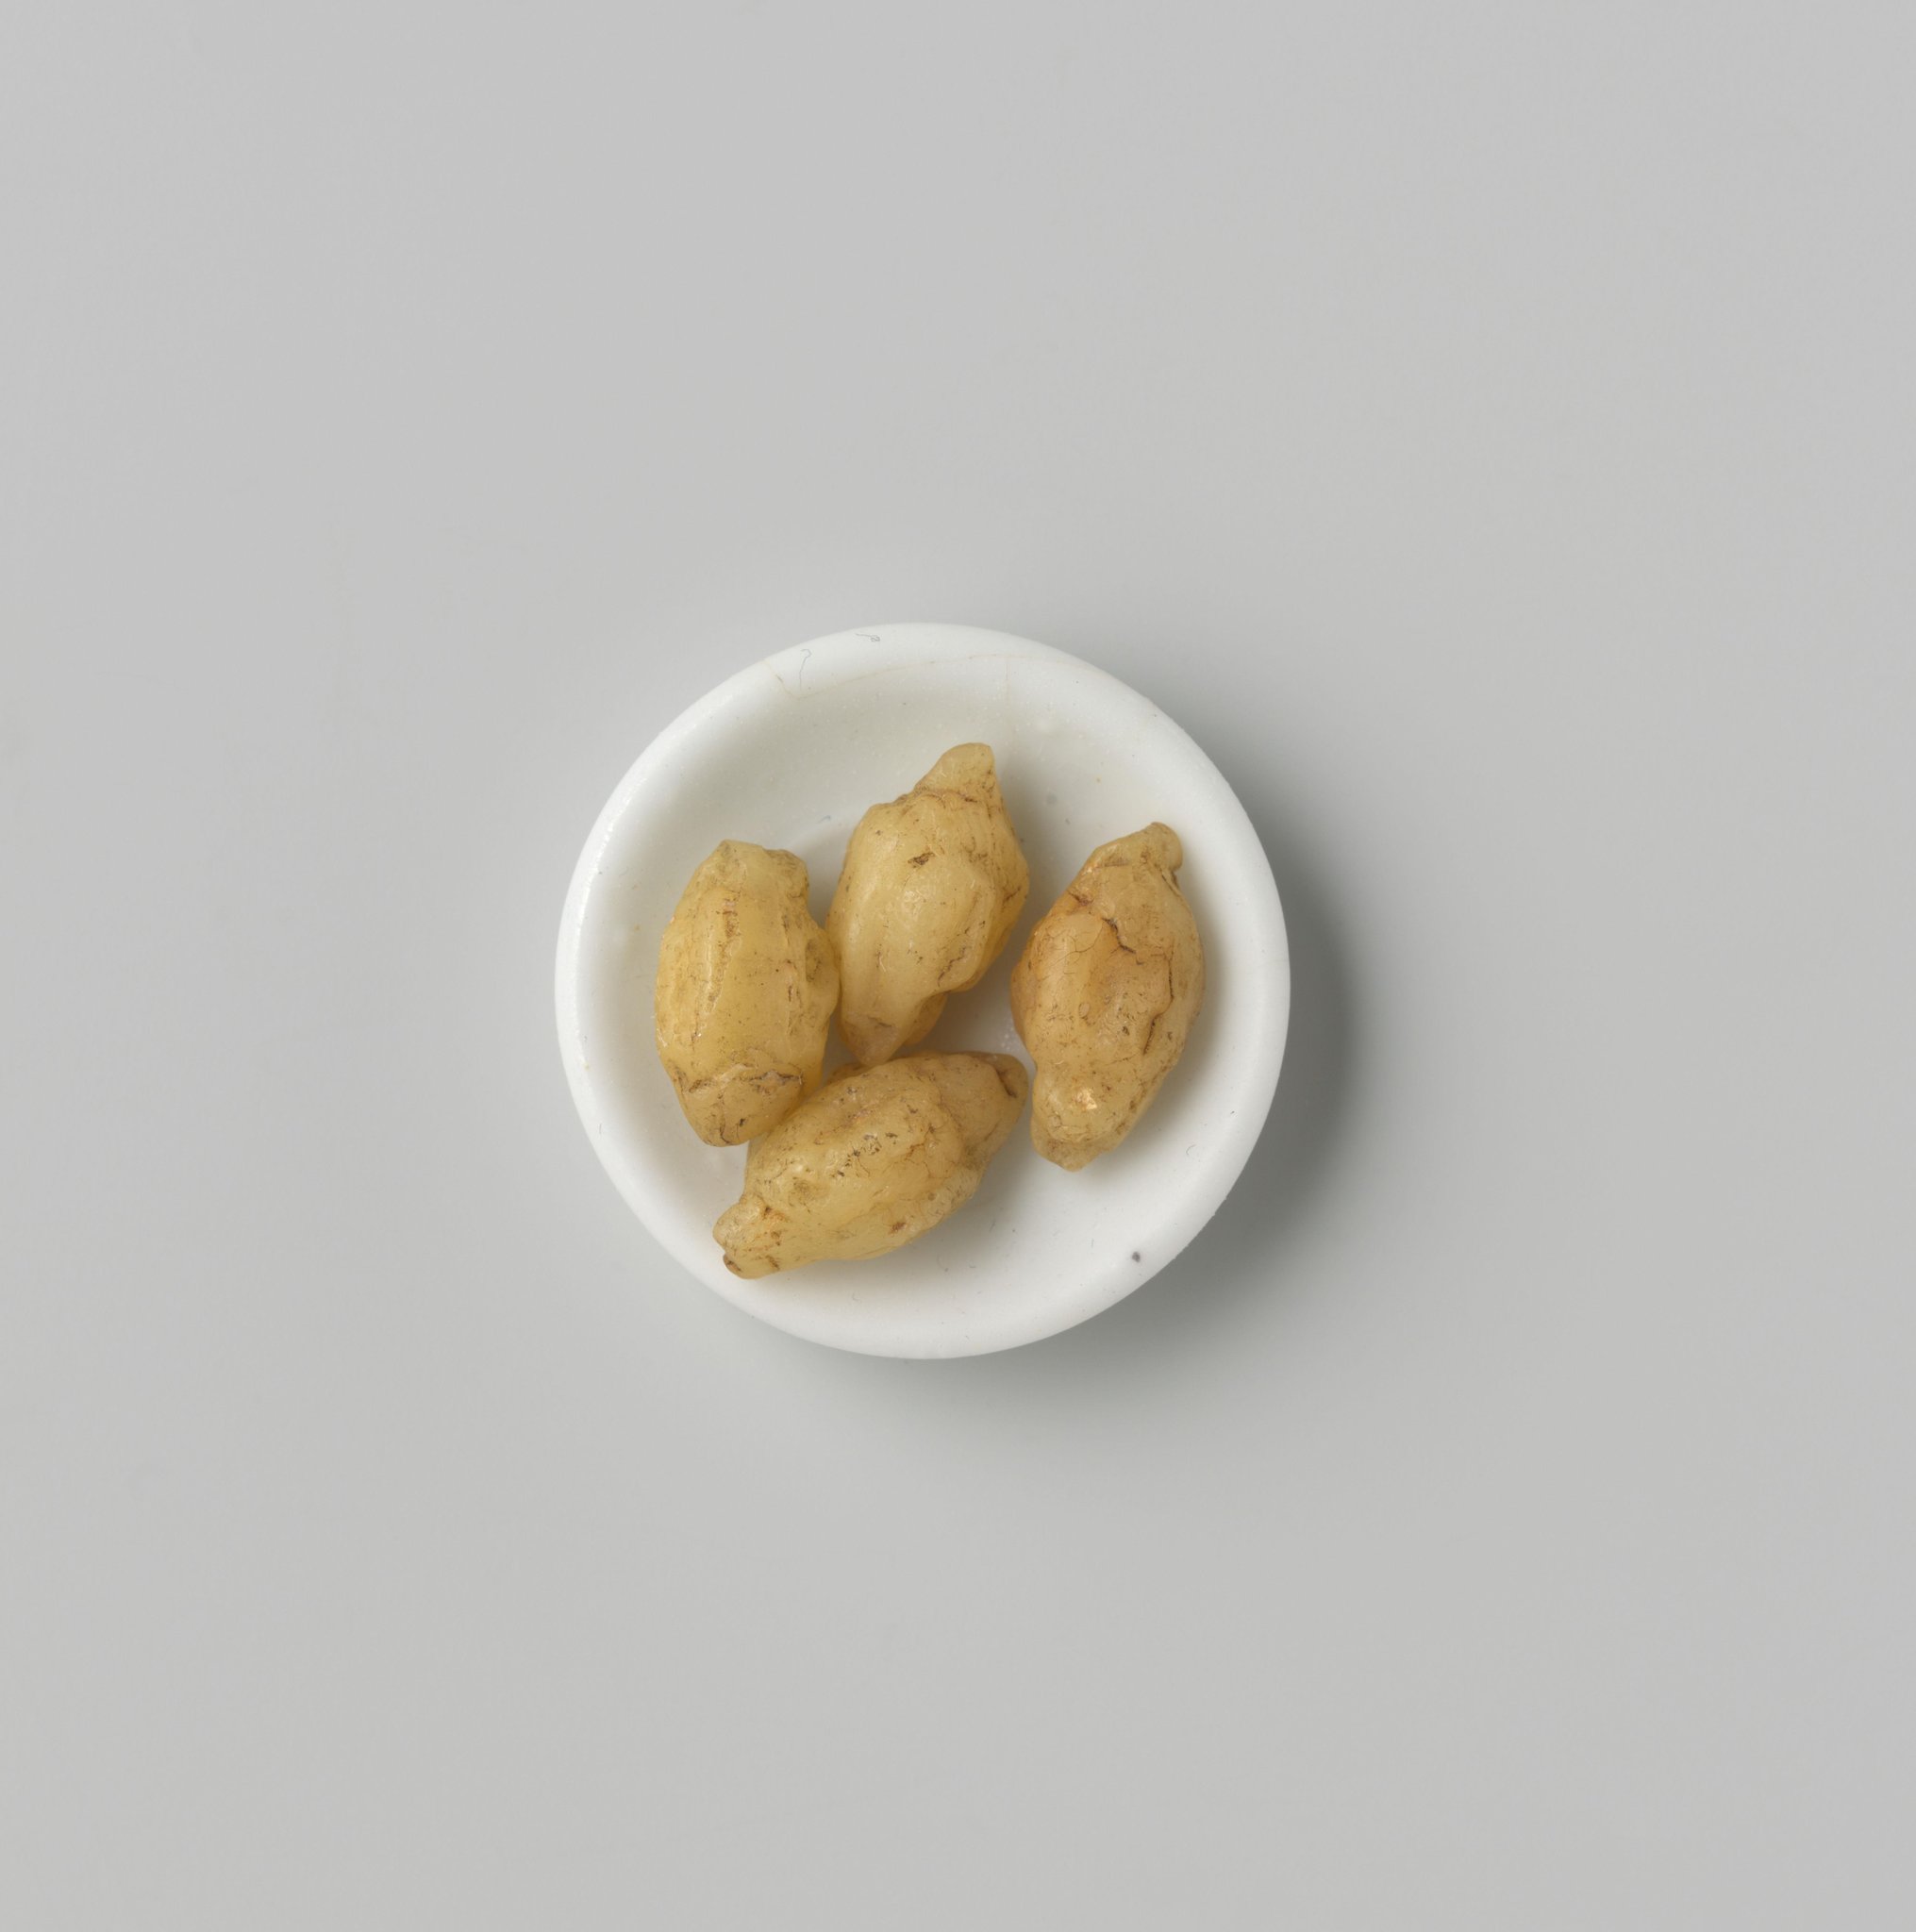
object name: miniature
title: Bord van opaak wit glas (waarschijnlijk imitatie wit aardewerk); met ribbel van opgelegde glasdraad.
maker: Anonymous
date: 1675-1710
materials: glass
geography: amsterdam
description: Bord van opaak wit glas, waarschijnlijk imitatie wit aardewerk, dubbelwandig met ribbel van opgelegde glasdraad.